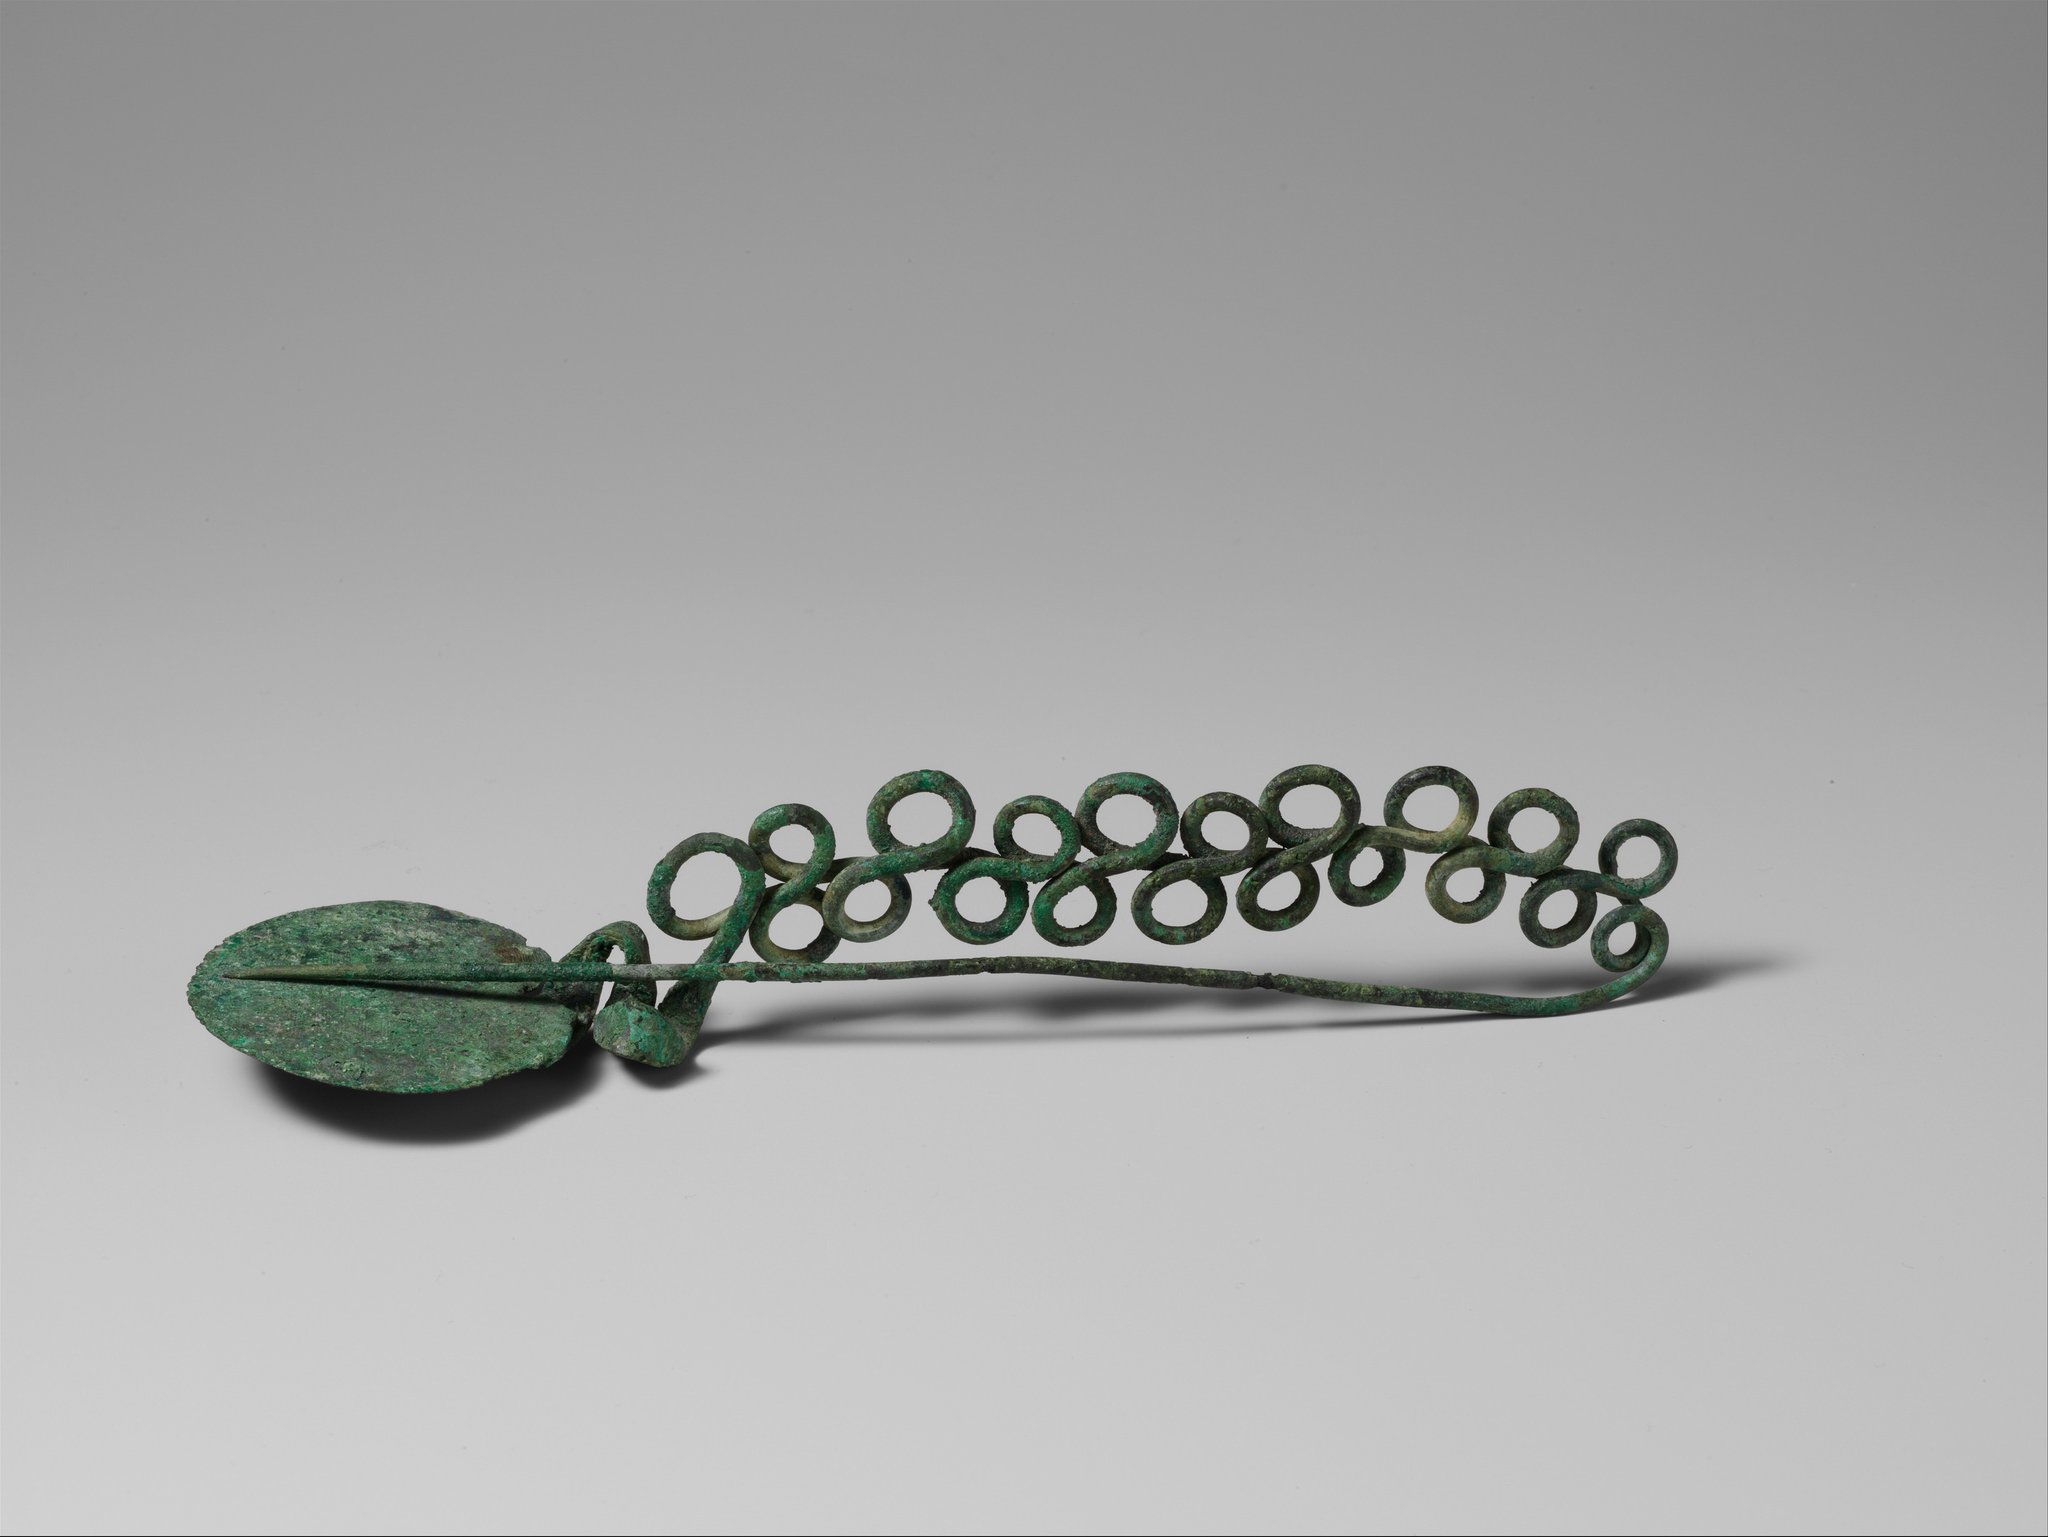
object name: fibula, disk type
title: Bronze disc-type fibula (safety pin)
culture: italic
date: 1000-901 BCE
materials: bronze